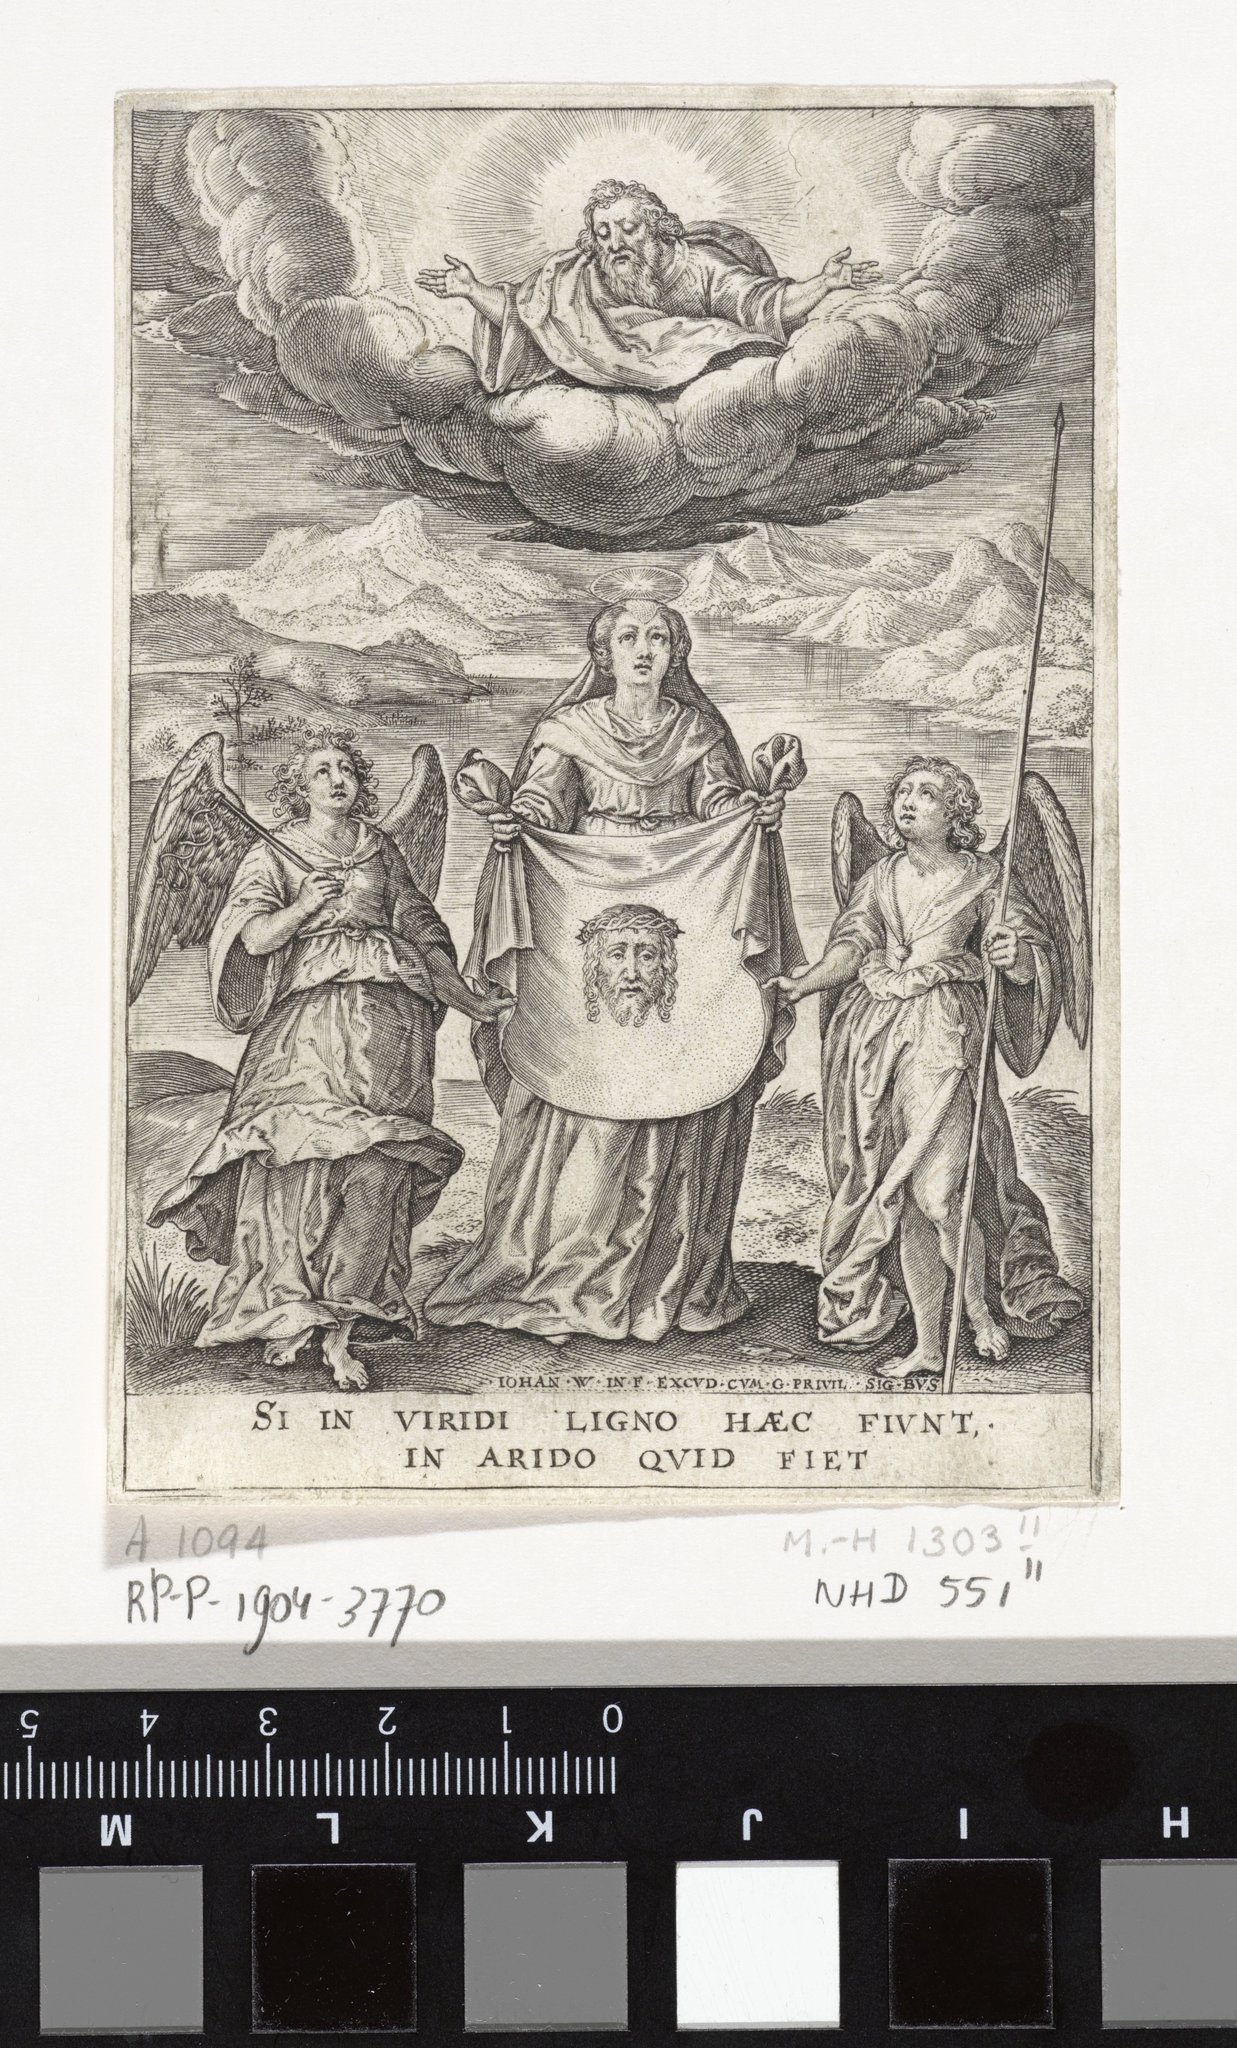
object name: print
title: H. Veronica met het sudarium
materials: paper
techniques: engraving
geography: antwerp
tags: 'vera icon', held up by veronica (+ angel(s)), god the father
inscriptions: collector's mark: Lugt 2228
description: Landschap met de heilige Veronica, geflankeerd door engelen met passiewerktuigen. In haar handen houdt ze het sudarium, de zweetdoek met een afbeelding van het gelaat van Christus. Ze kijken op naar God de Vader in de wolken. In de marge een tweeregelig onderschrift in het Latijn.